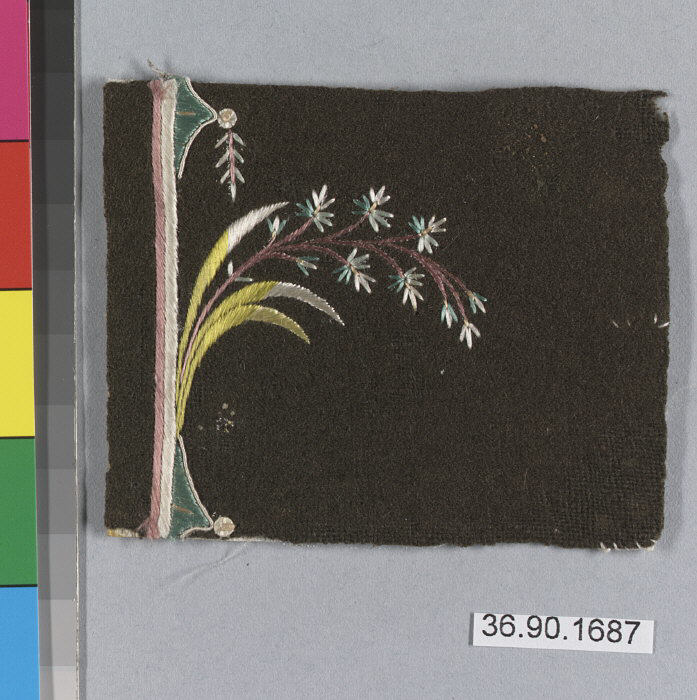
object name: sample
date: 1801-1833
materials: felt, silk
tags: plants